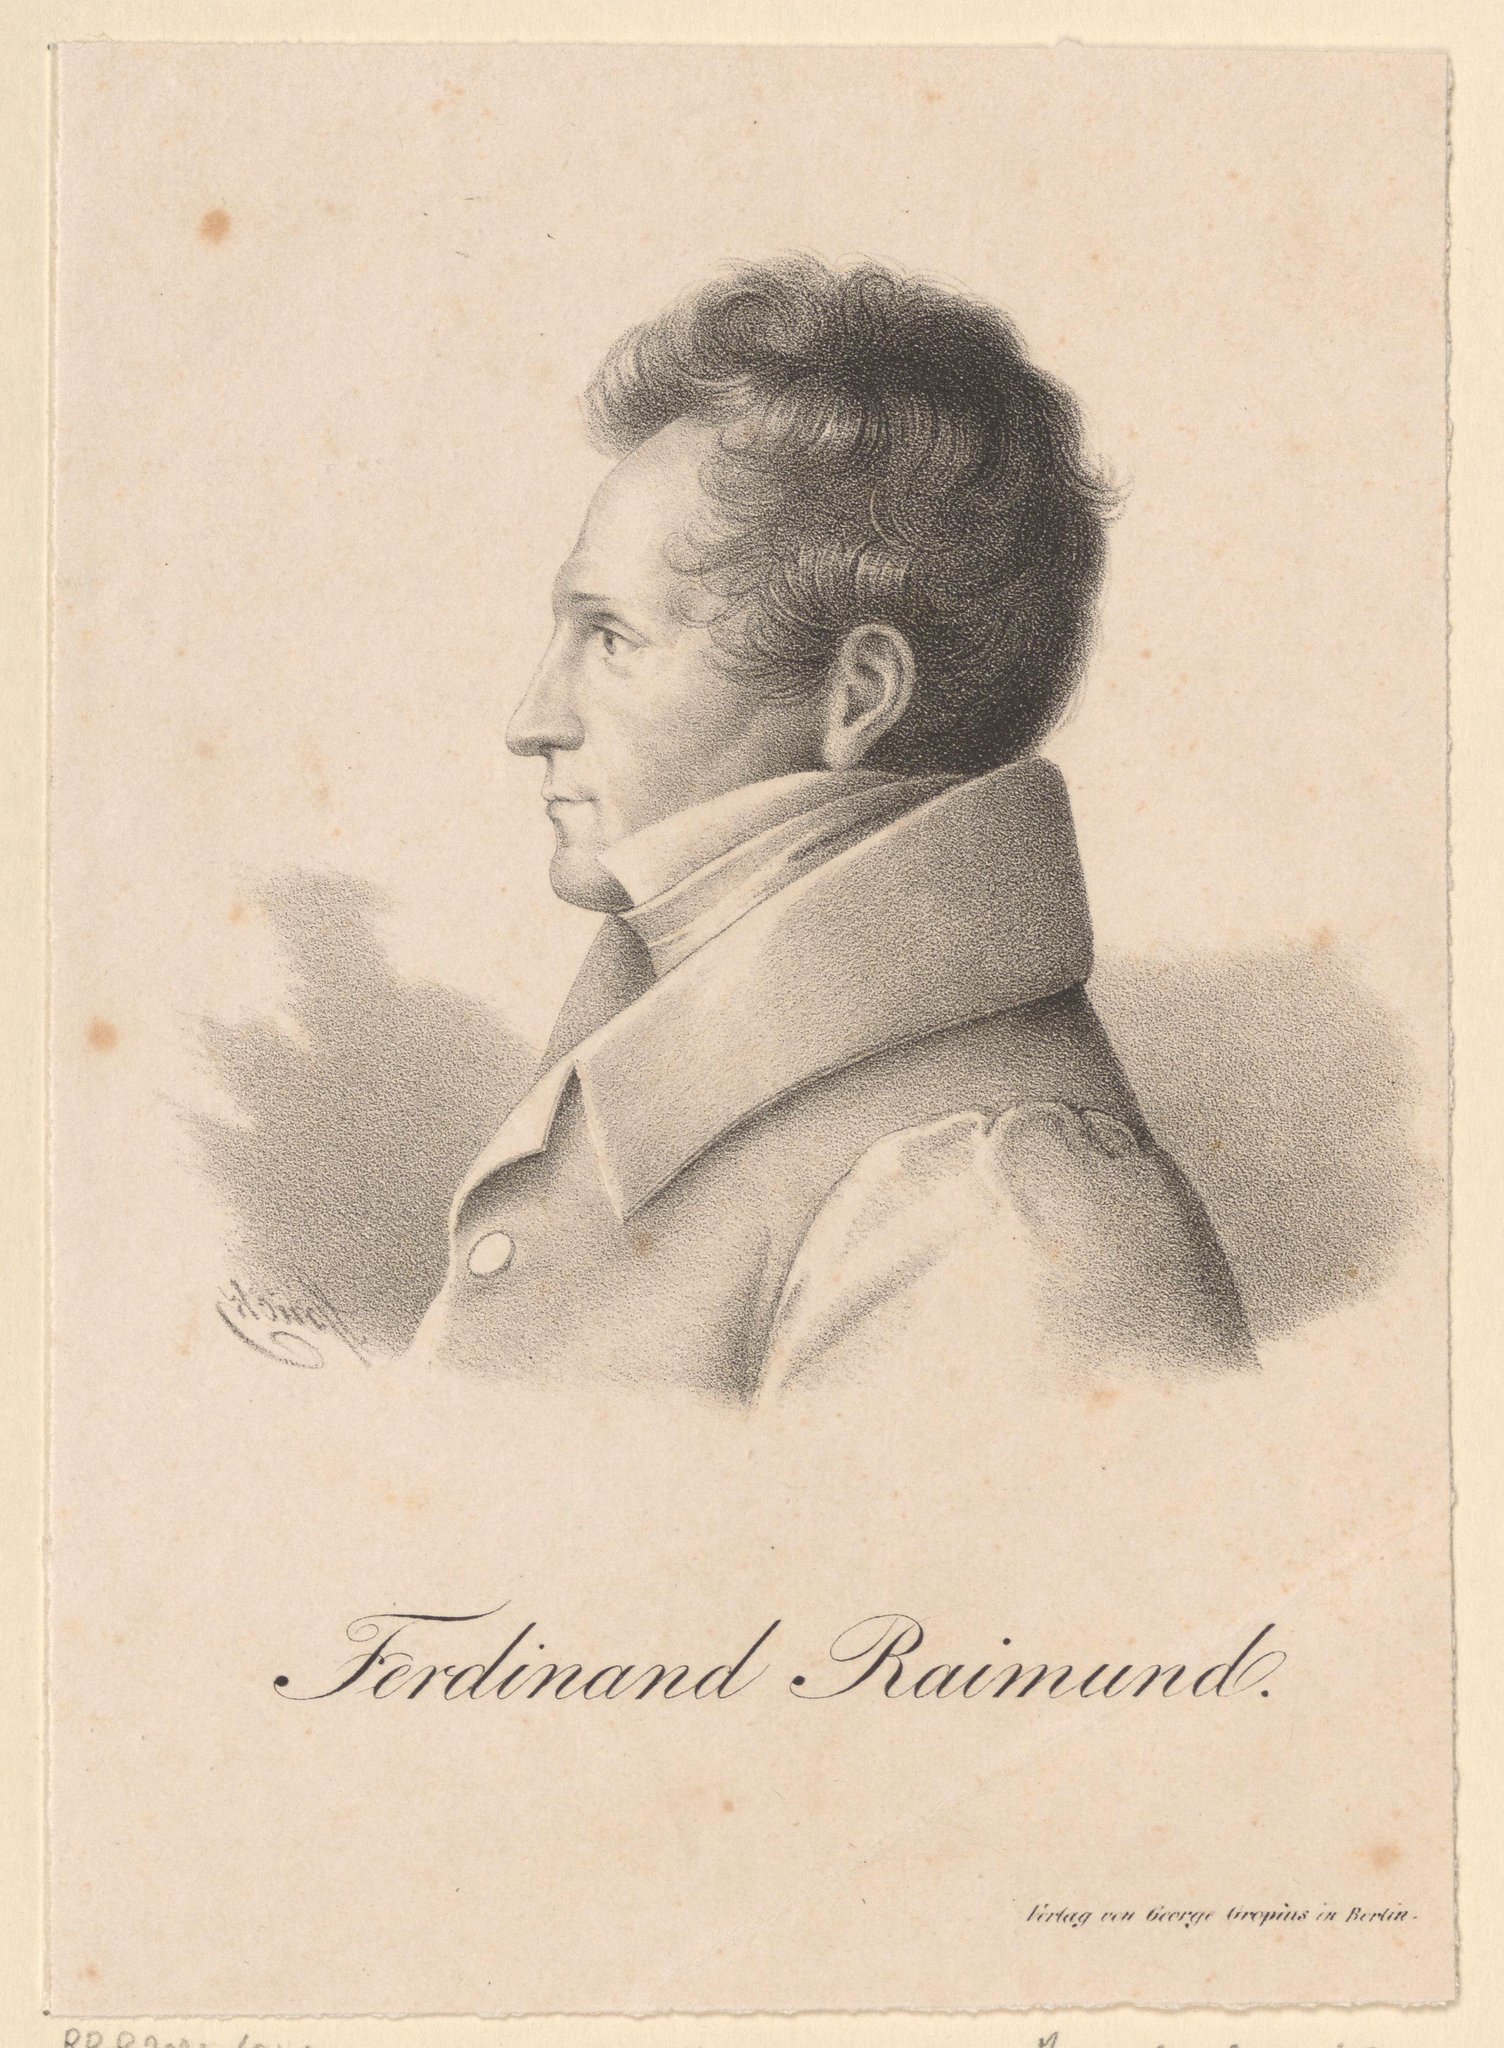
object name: print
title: Portret van Ferdinand Raimund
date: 1818-1842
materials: paper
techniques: lithograph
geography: berlin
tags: historical persons